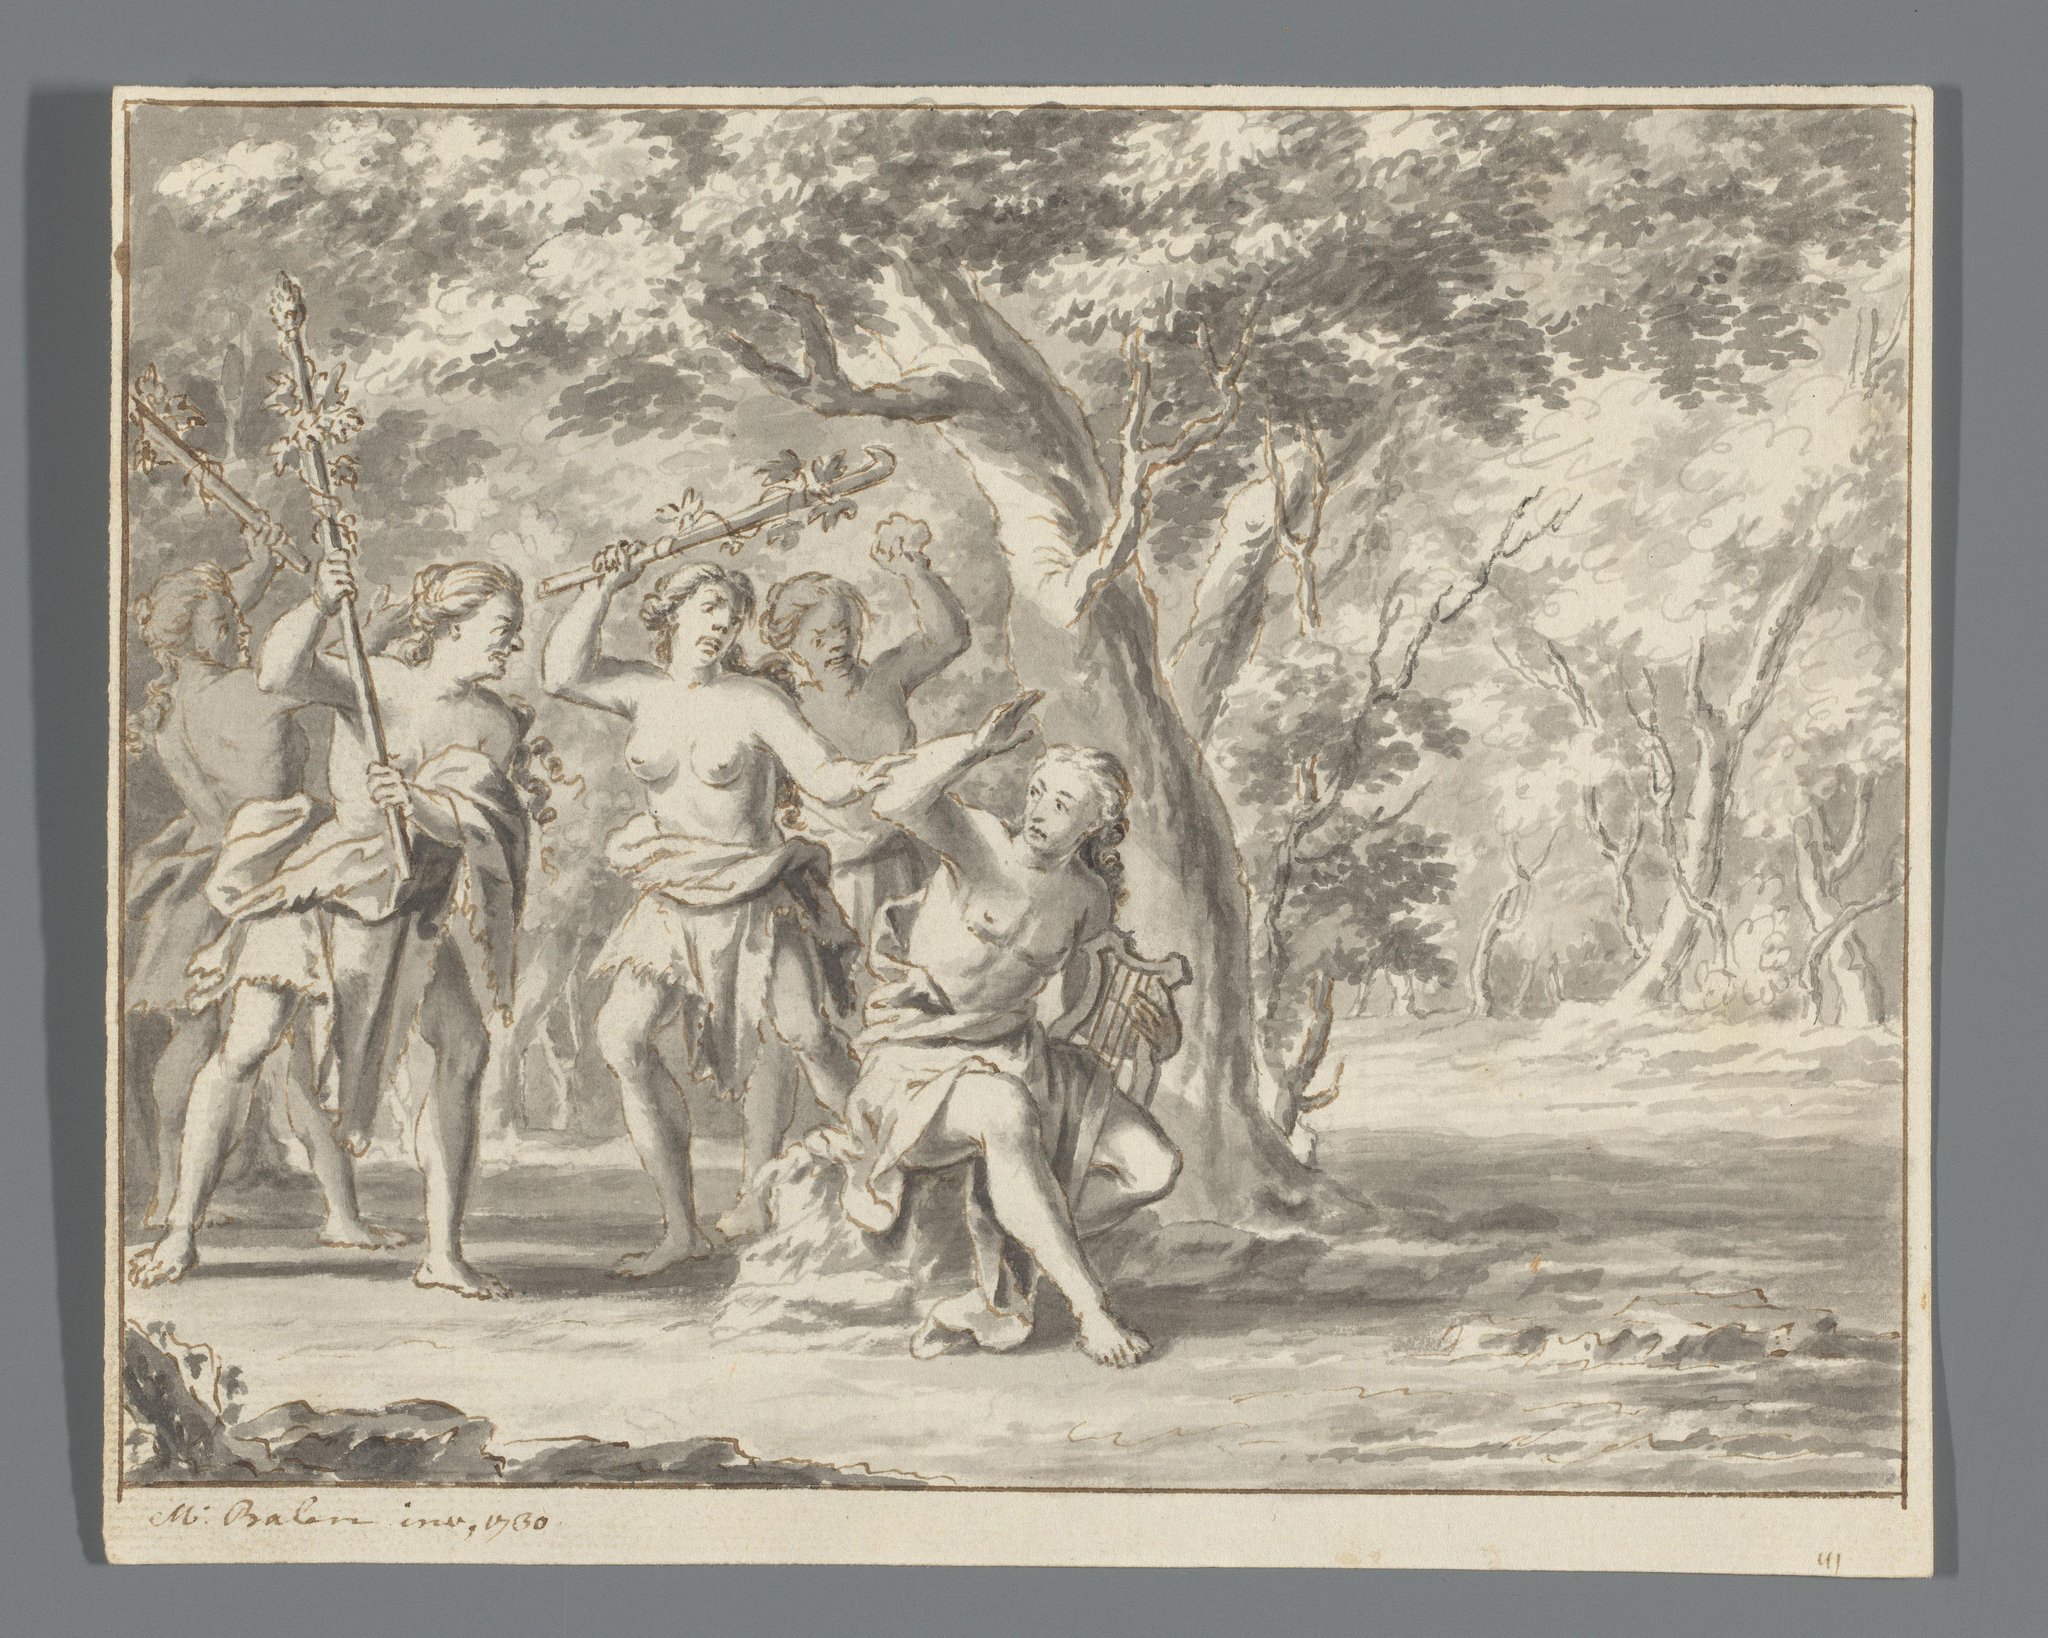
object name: drawing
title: Dood van Orpheus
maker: matthijs balen (1684-1766)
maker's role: draughtsman, painter, print maker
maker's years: 1684-1766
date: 1730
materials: paper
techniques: brush, pen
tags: death of orpheus: he is torn to pieces by the thracian women during a bacchic orgy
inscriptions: date